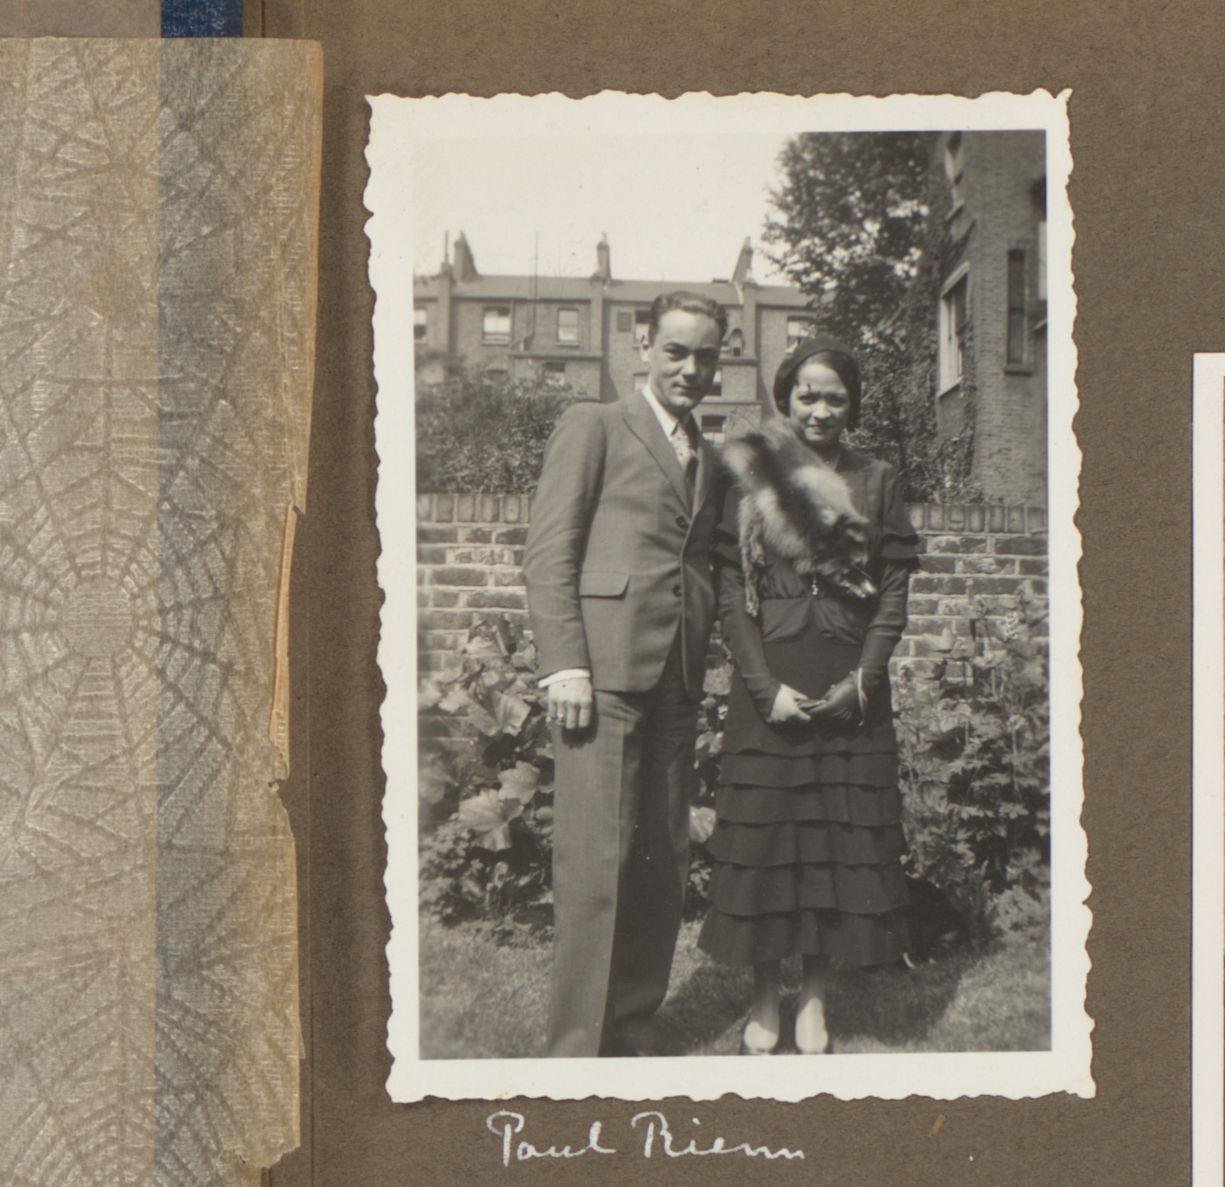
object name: photograph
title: Portret van Paul Riem en Wilhelmina van Zijll de Jong in een tuin, Londen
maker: Anonymous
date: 1906-1932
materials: paper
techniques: gelatin silver print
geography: london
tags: wilhelmina van zijll de jong, historical persons, london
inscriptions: inscription: ‘Paul Riem’